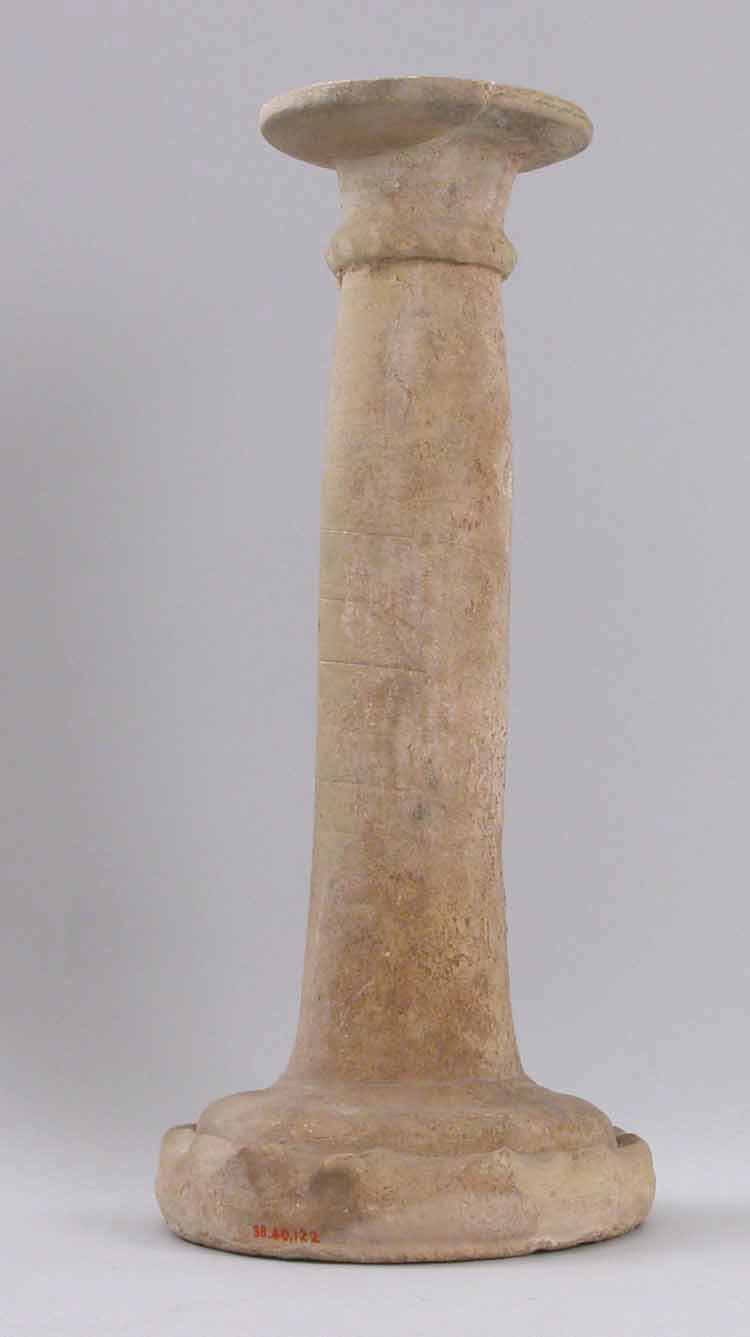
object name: stand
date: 867-933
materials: earthenware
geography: iran